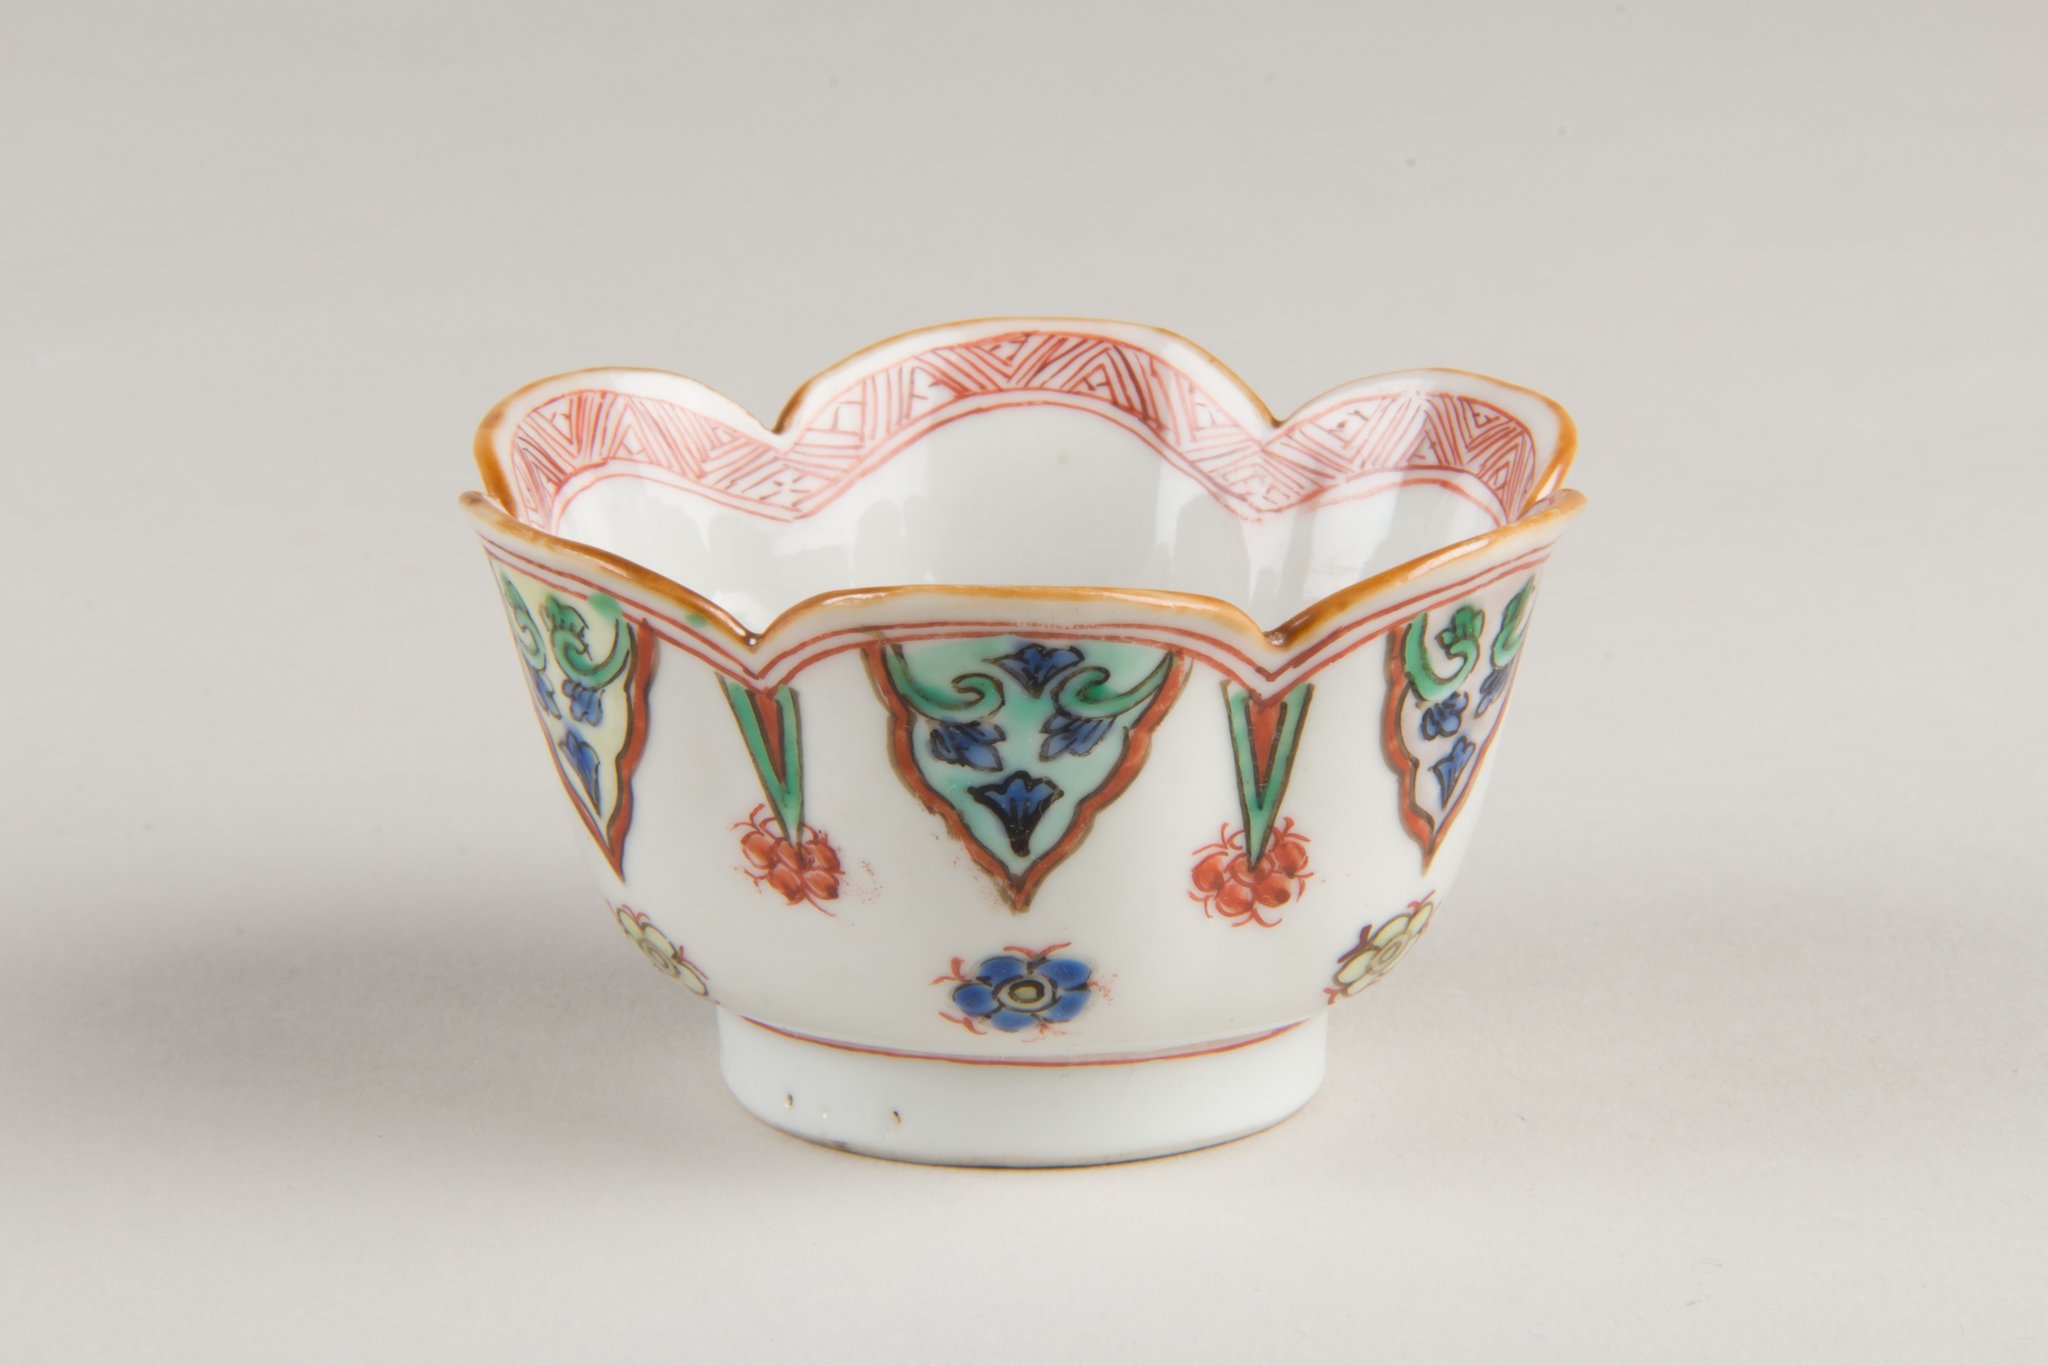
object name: cup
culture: chinese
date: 1801-1850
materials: enamel, porcelain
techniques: overglaze, painting, polychrome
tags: flowers